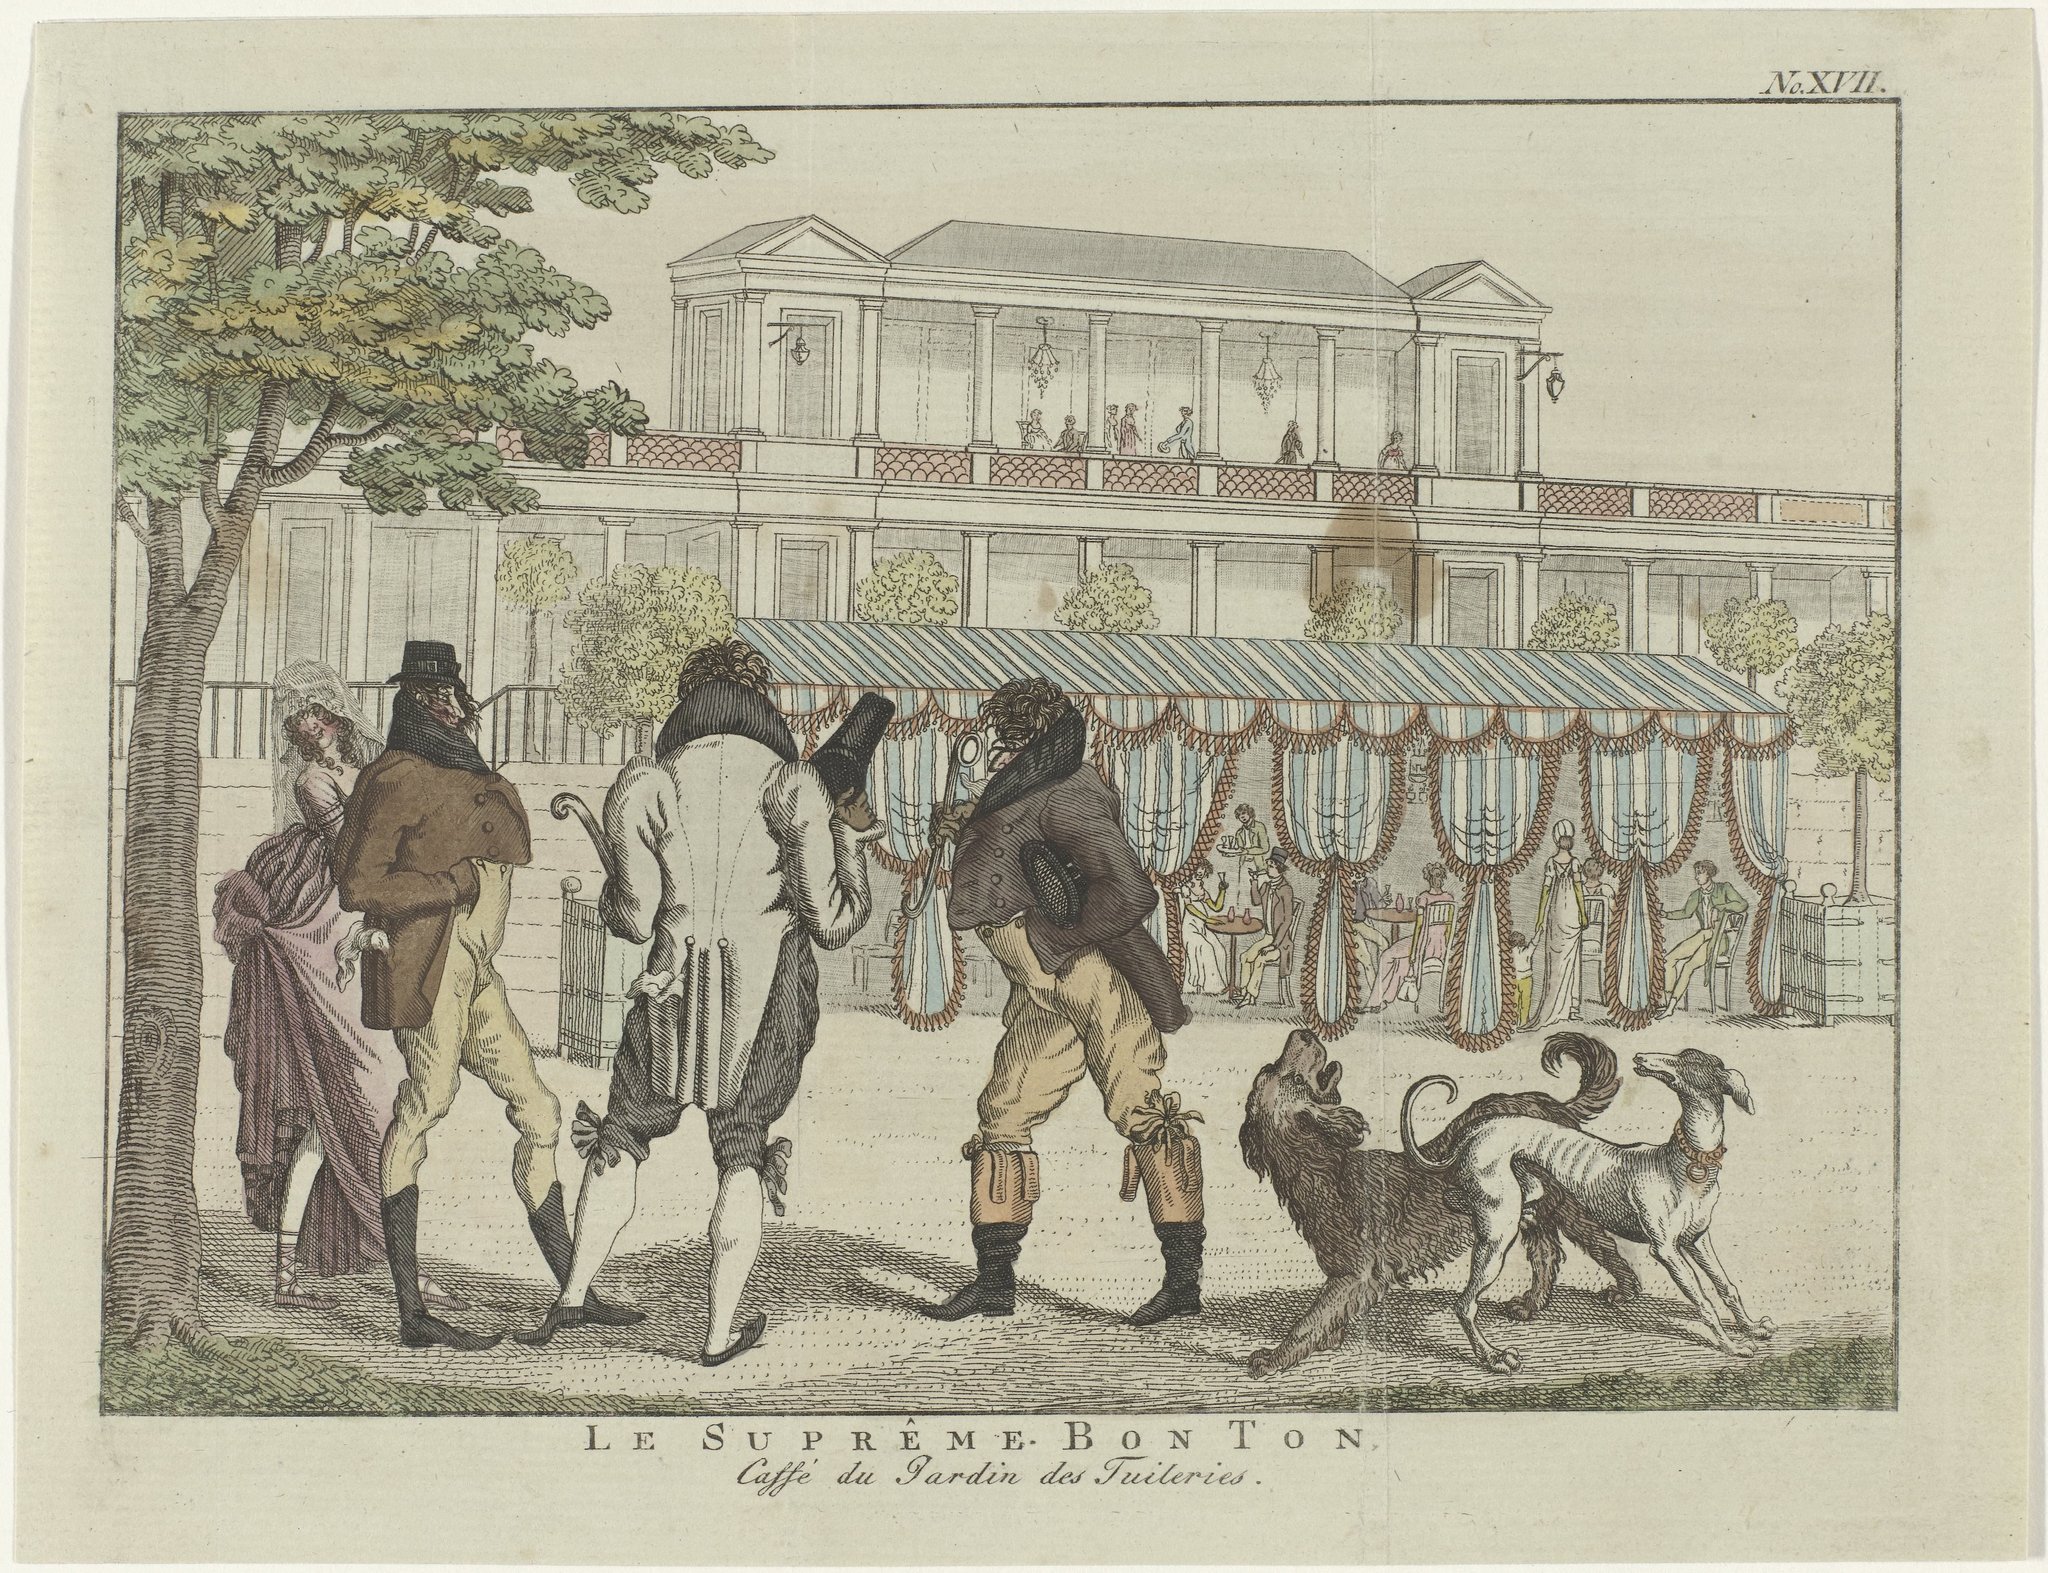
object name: fashion print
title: Le Suprême Bon Ton, 1800-1815, No. 27: Café du Jardin des Tuileries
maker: Anonymous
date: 1800-1815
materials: paper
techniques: etching, hand coloring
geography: france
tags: fashion plates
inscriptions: title: ‘Le Suprême Bon Ton’, title: ‘Café du Jardin des Tuileries’, number: ‘No. XVII.’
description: Waarschijnlijk is dit een verkleinde kopie naar prent No. 27 uit de serie van 30 modeprenten, Le Suprême Bon Ton, Parijs, 1800-1815.